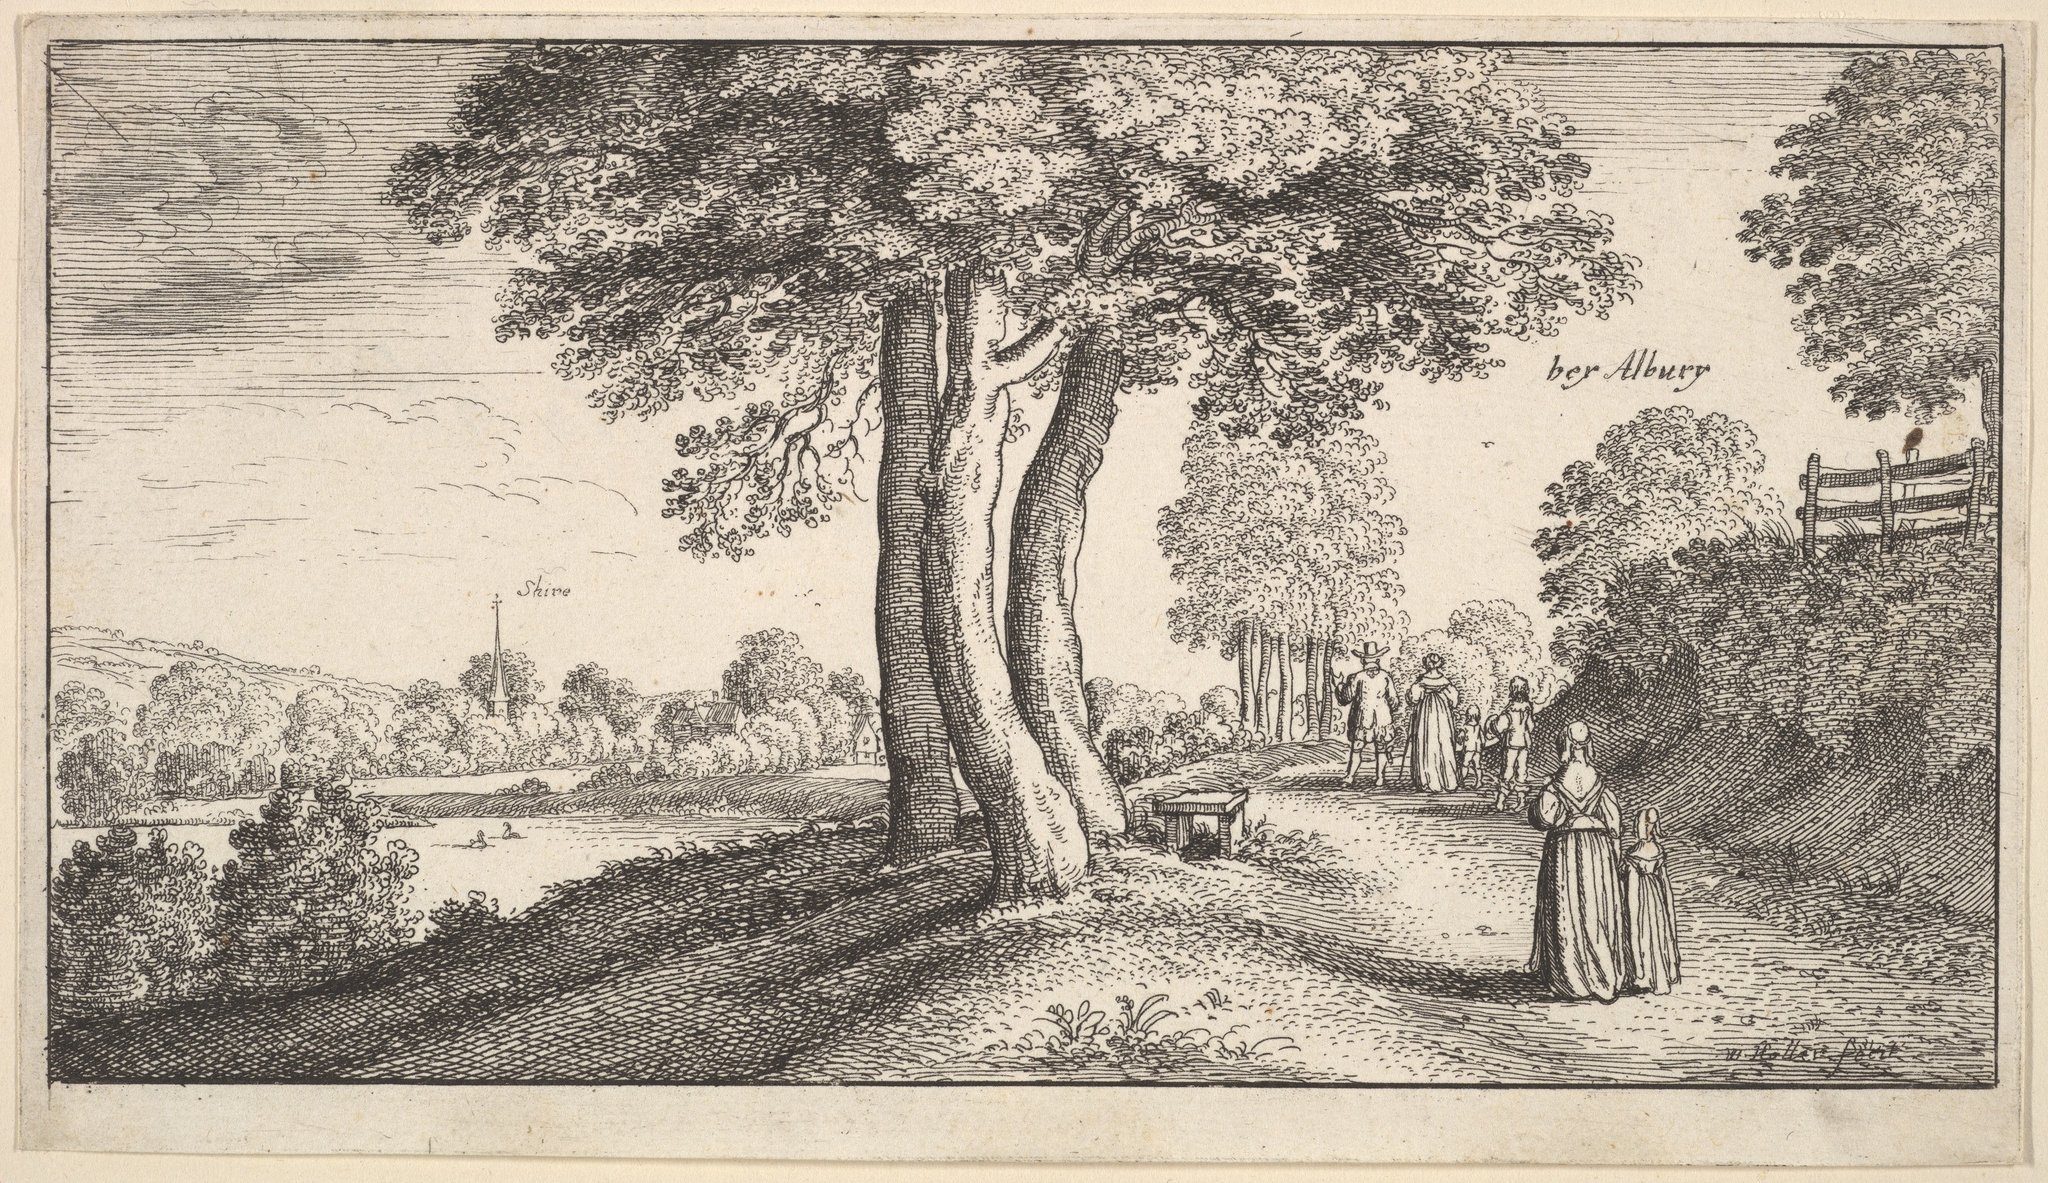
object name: print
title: View Near Albury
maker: wenceslaus hollar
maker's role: artist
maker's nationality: bohemian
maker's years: 1607-1677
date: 1645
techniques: etching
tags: men,women,trees